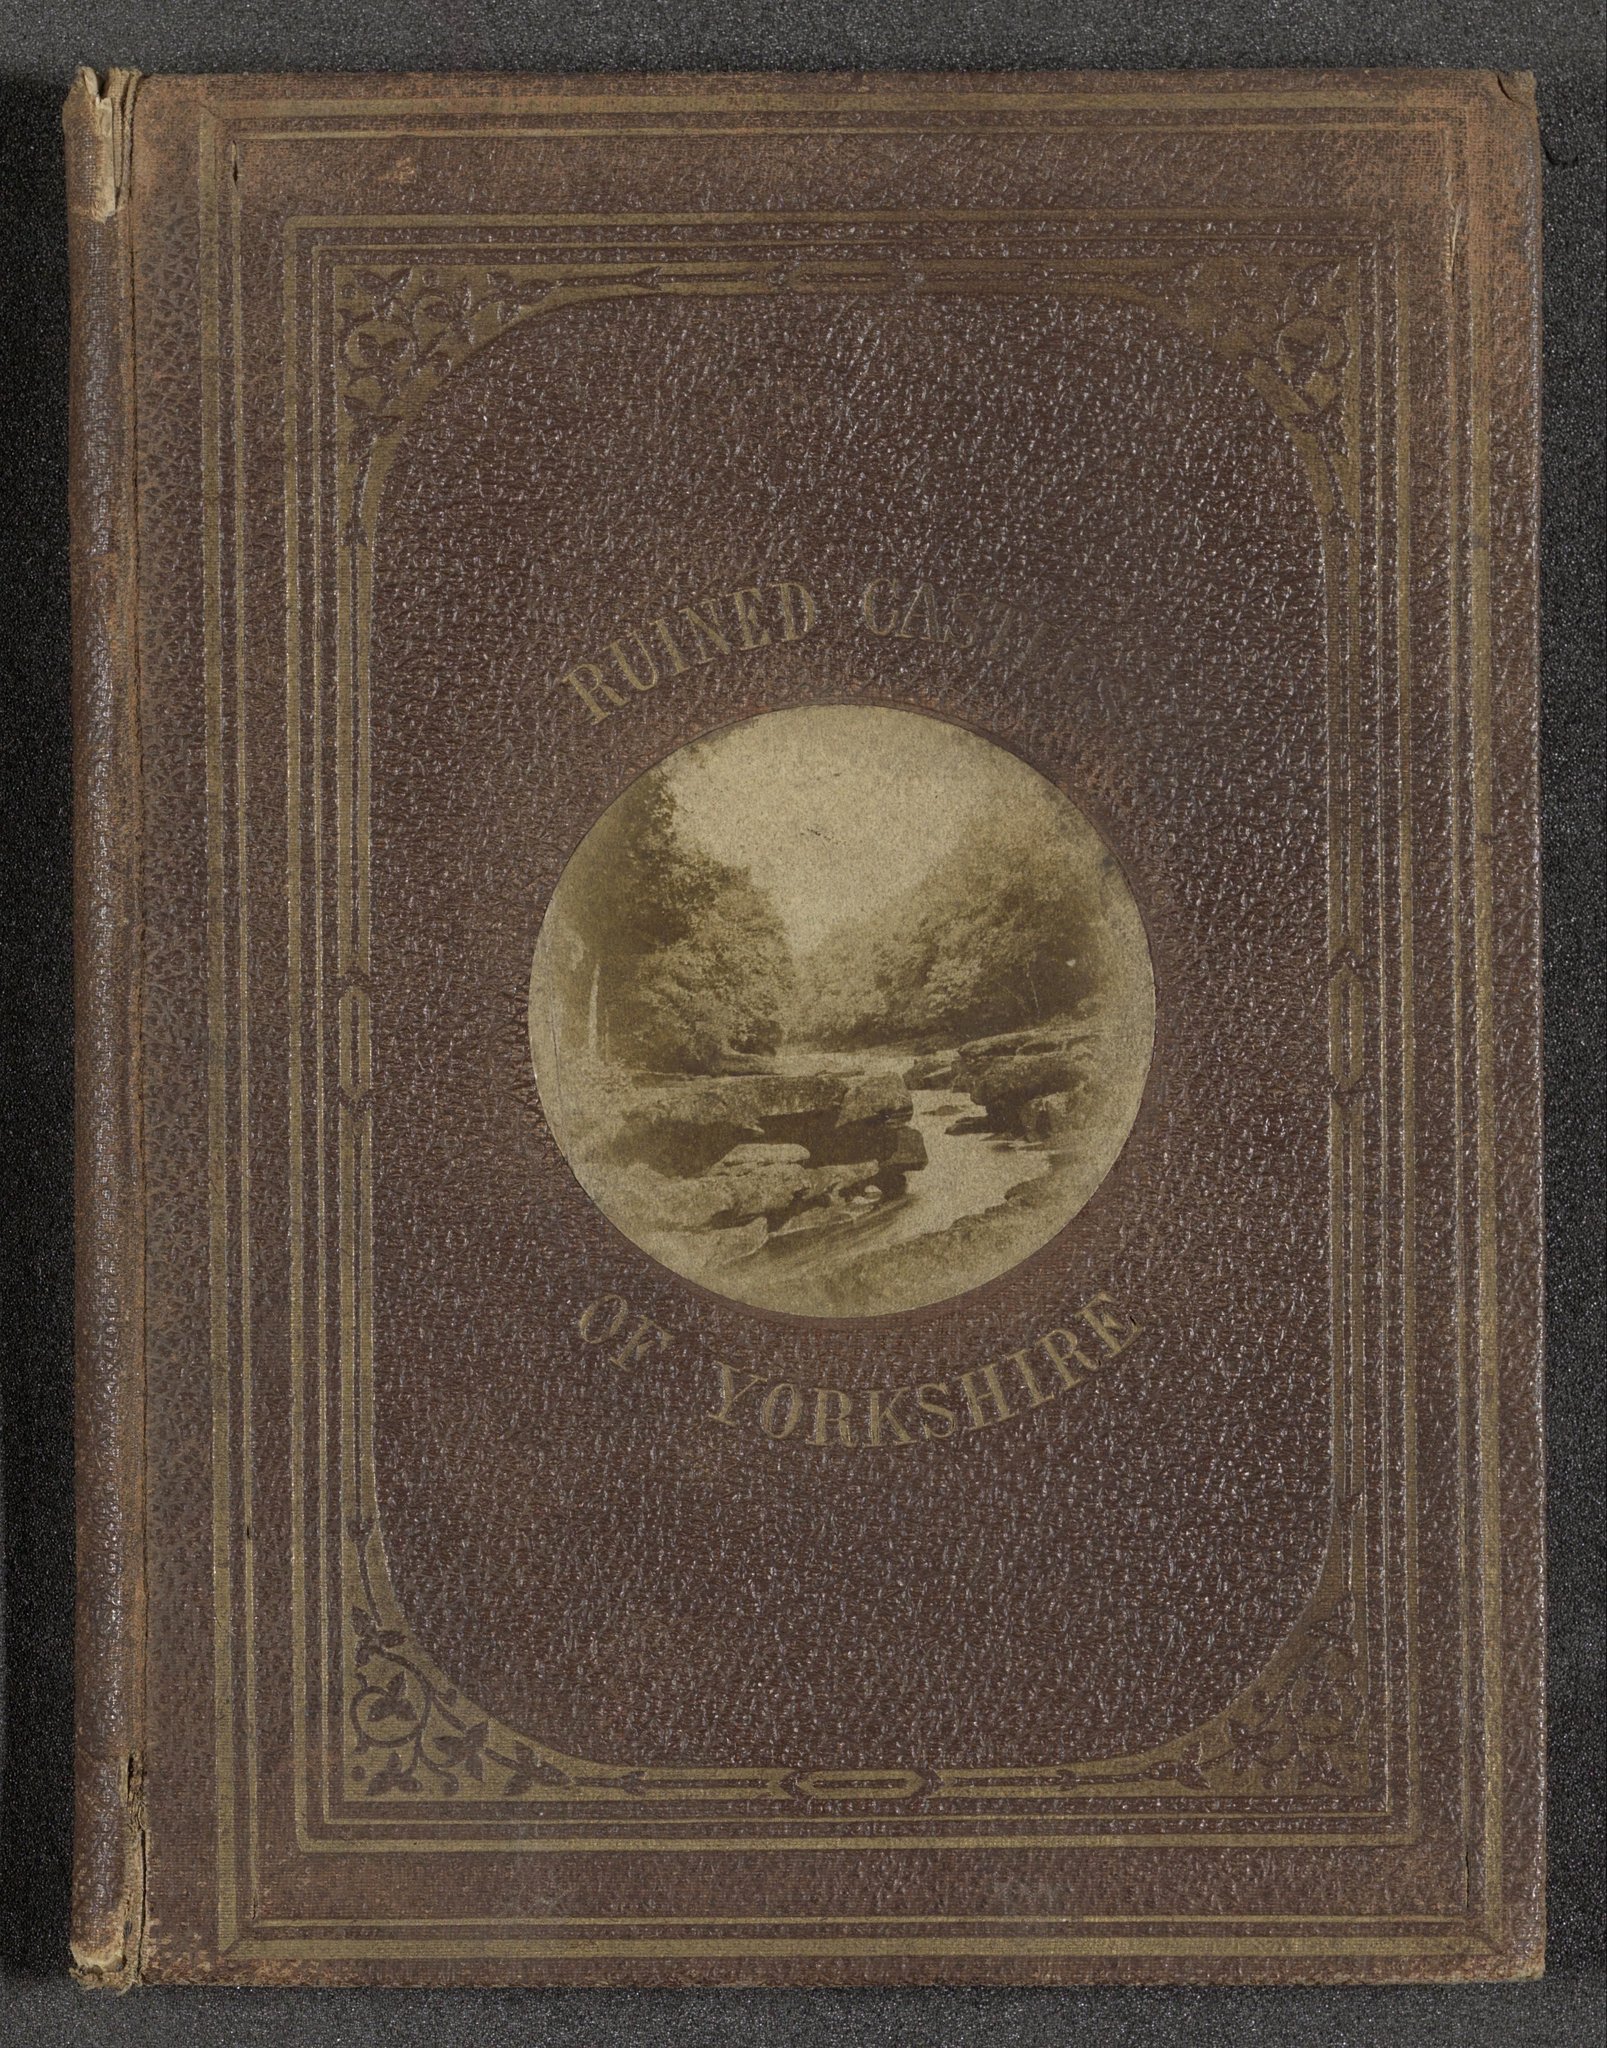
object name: page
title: Gezicht op de Bolton Strid vlakbij Bolton Abbey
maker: william russell sedgfield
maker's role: fotograaf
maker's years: 1826-1902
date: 1855-1865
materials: photographic support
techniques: albumen print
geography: bolton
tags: river